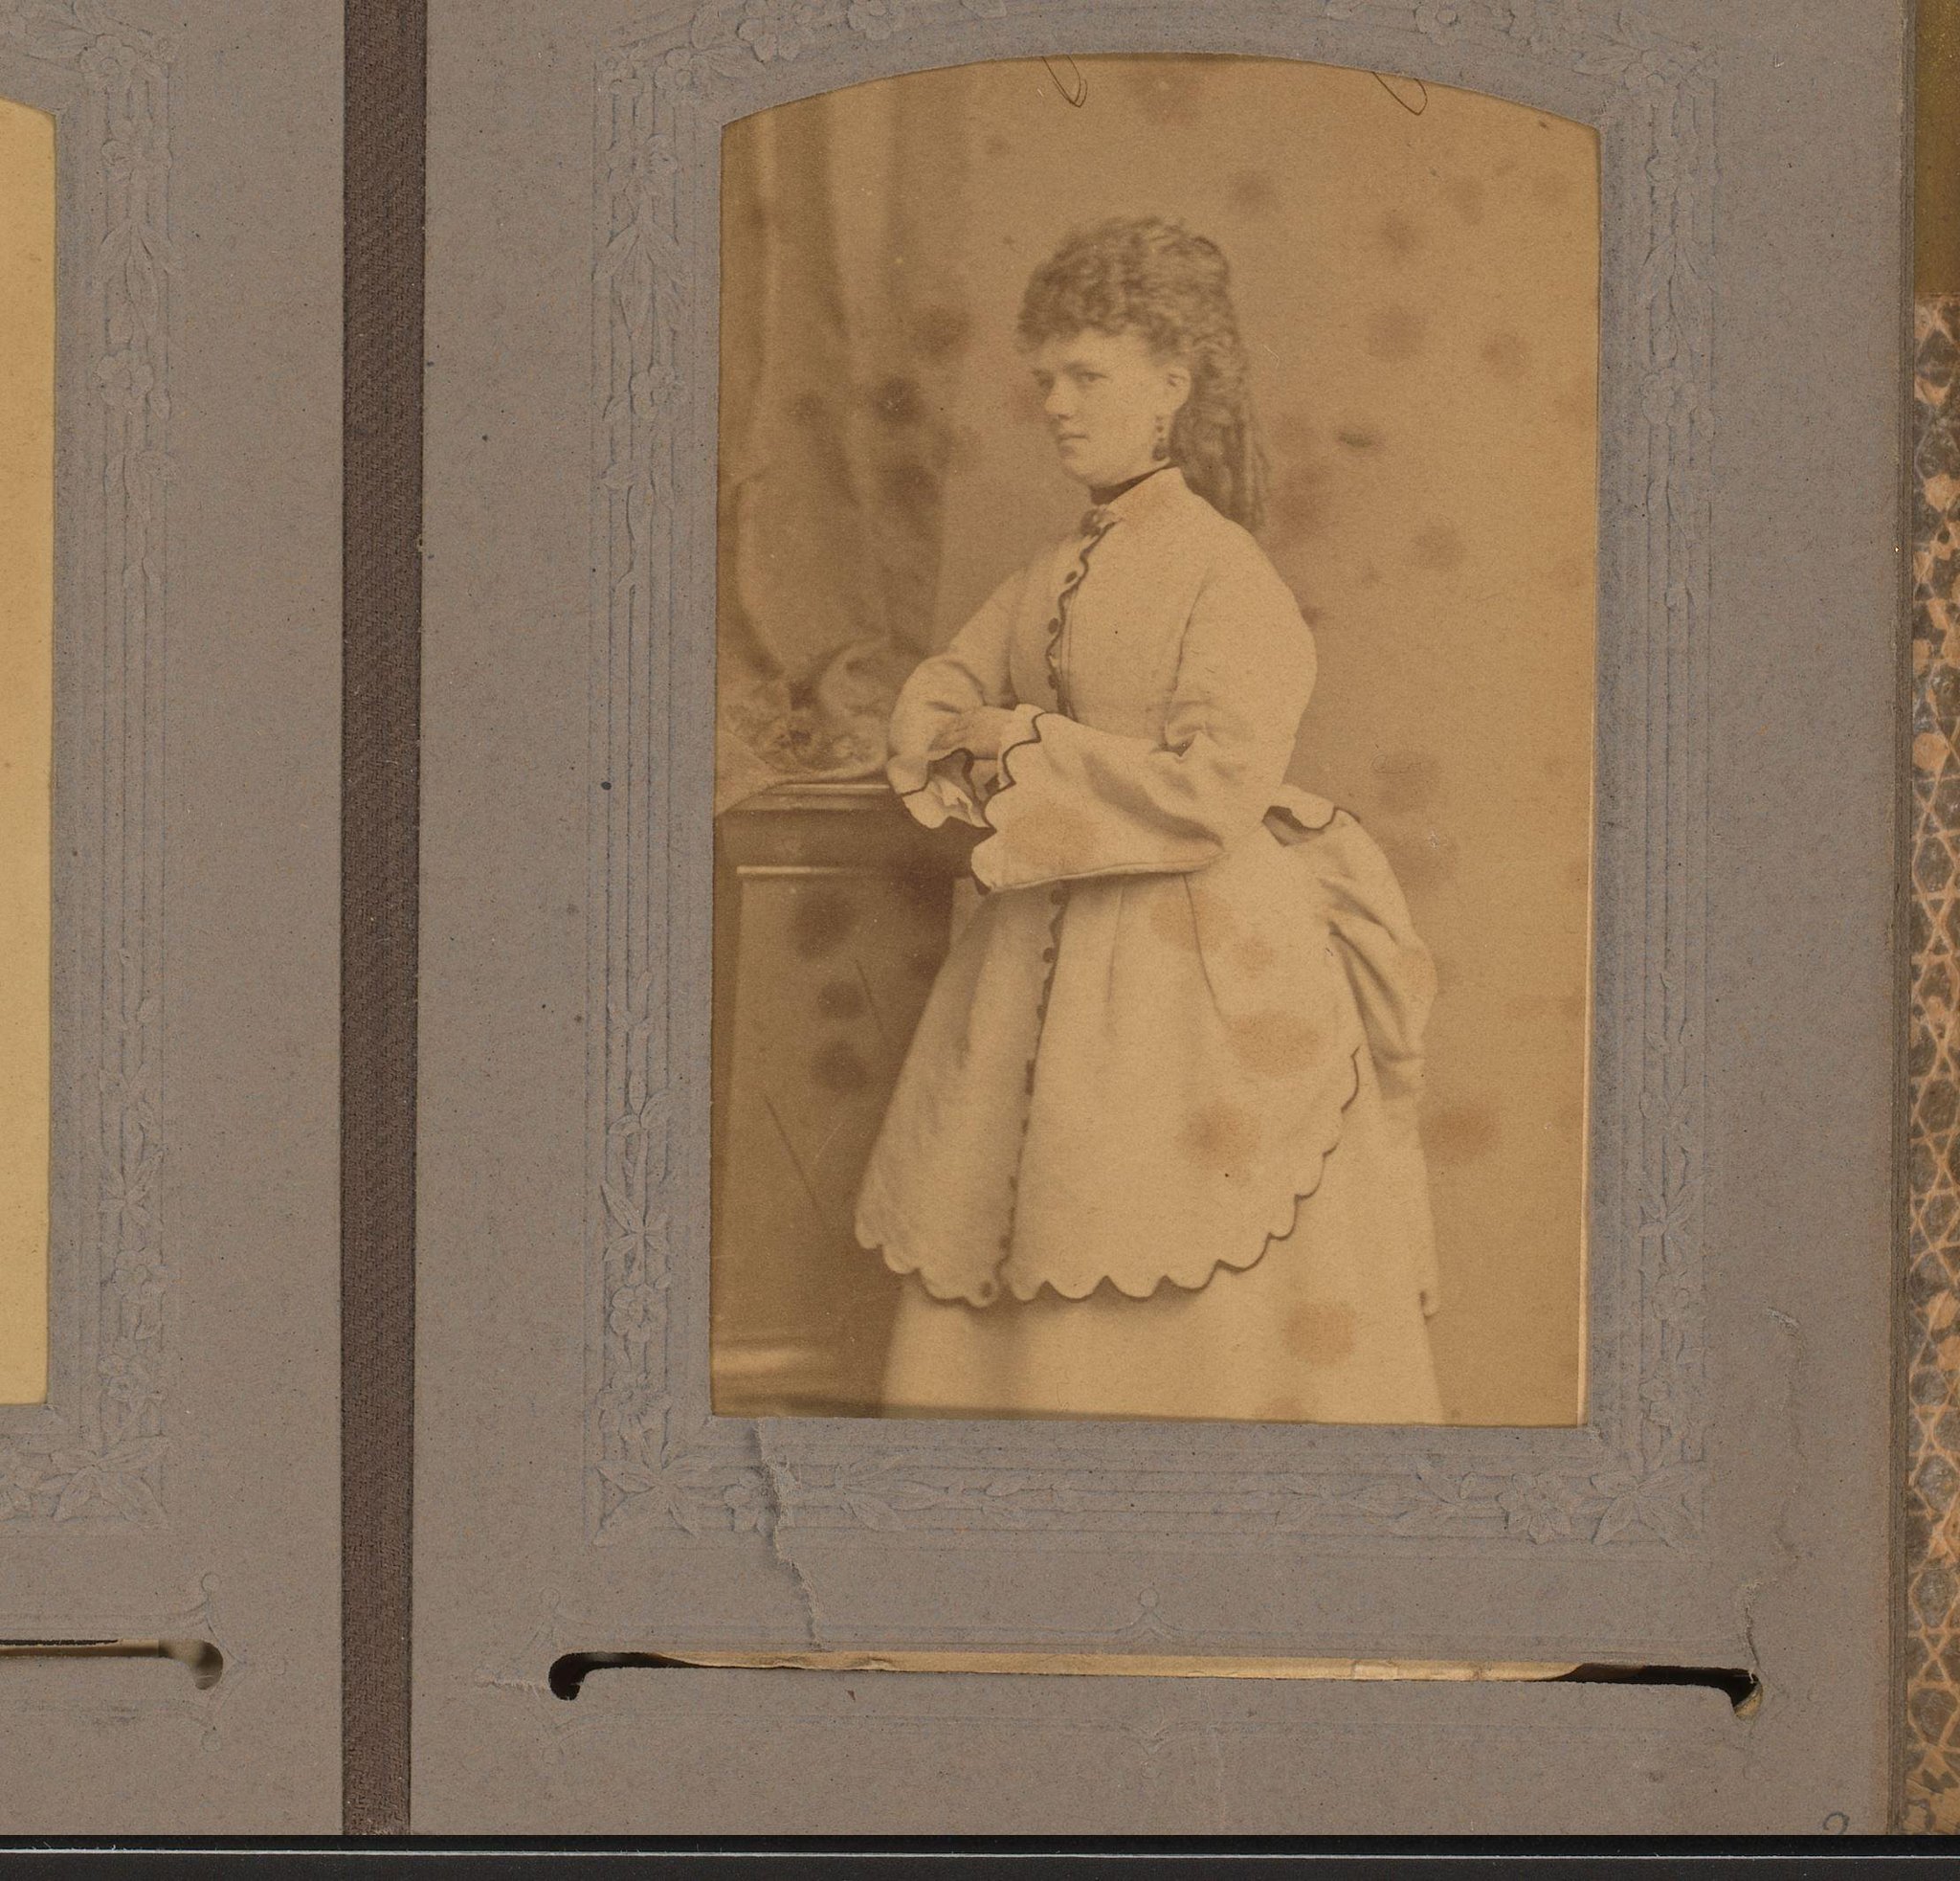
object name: album leaf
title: Portret van een staande vrouw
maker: albert greiner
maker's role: fotograaf, fotostudio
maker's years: 1833-1890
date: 1861-1874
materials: cardboard, photographic support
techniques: albumen print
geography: amsterdam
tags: historical persons - bb - woman, standing figure - aa - female human figure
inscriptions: inscription: ‘A. Greiner/ Photograf/ NIEUWENDIJK L. 87/ AMSTERDAM’